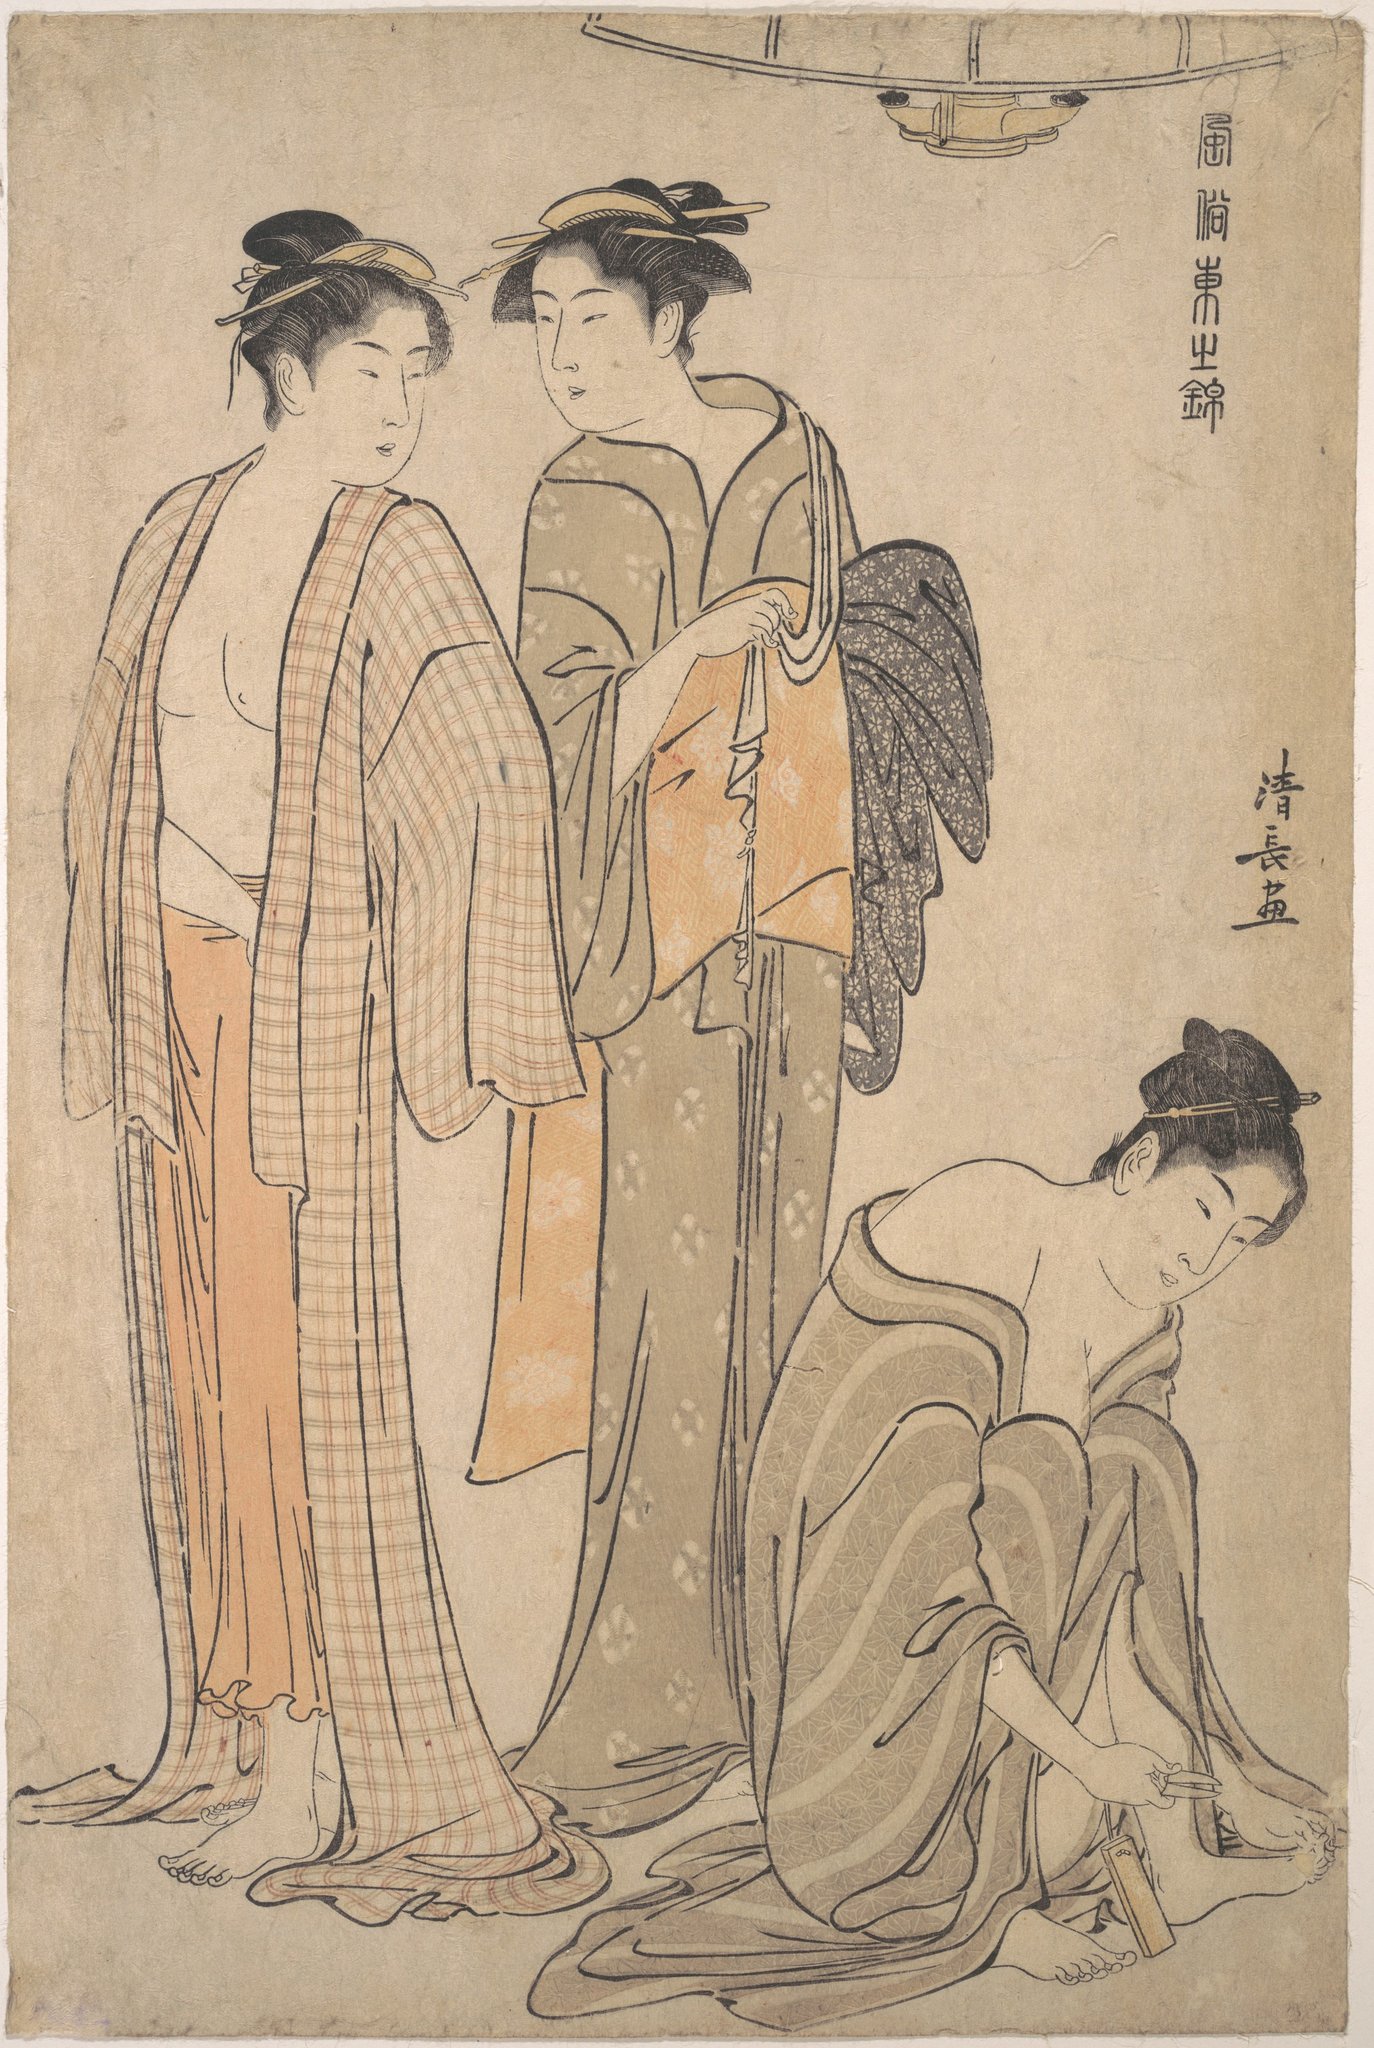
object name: print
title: Cutting the Toenails; the Toilet after the Bath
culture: japanese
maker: torii kiyonaga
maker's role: artist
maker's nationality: japanese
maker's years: 1752-1815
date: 1742-1815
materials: ink, paper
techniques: woodblock print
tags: women